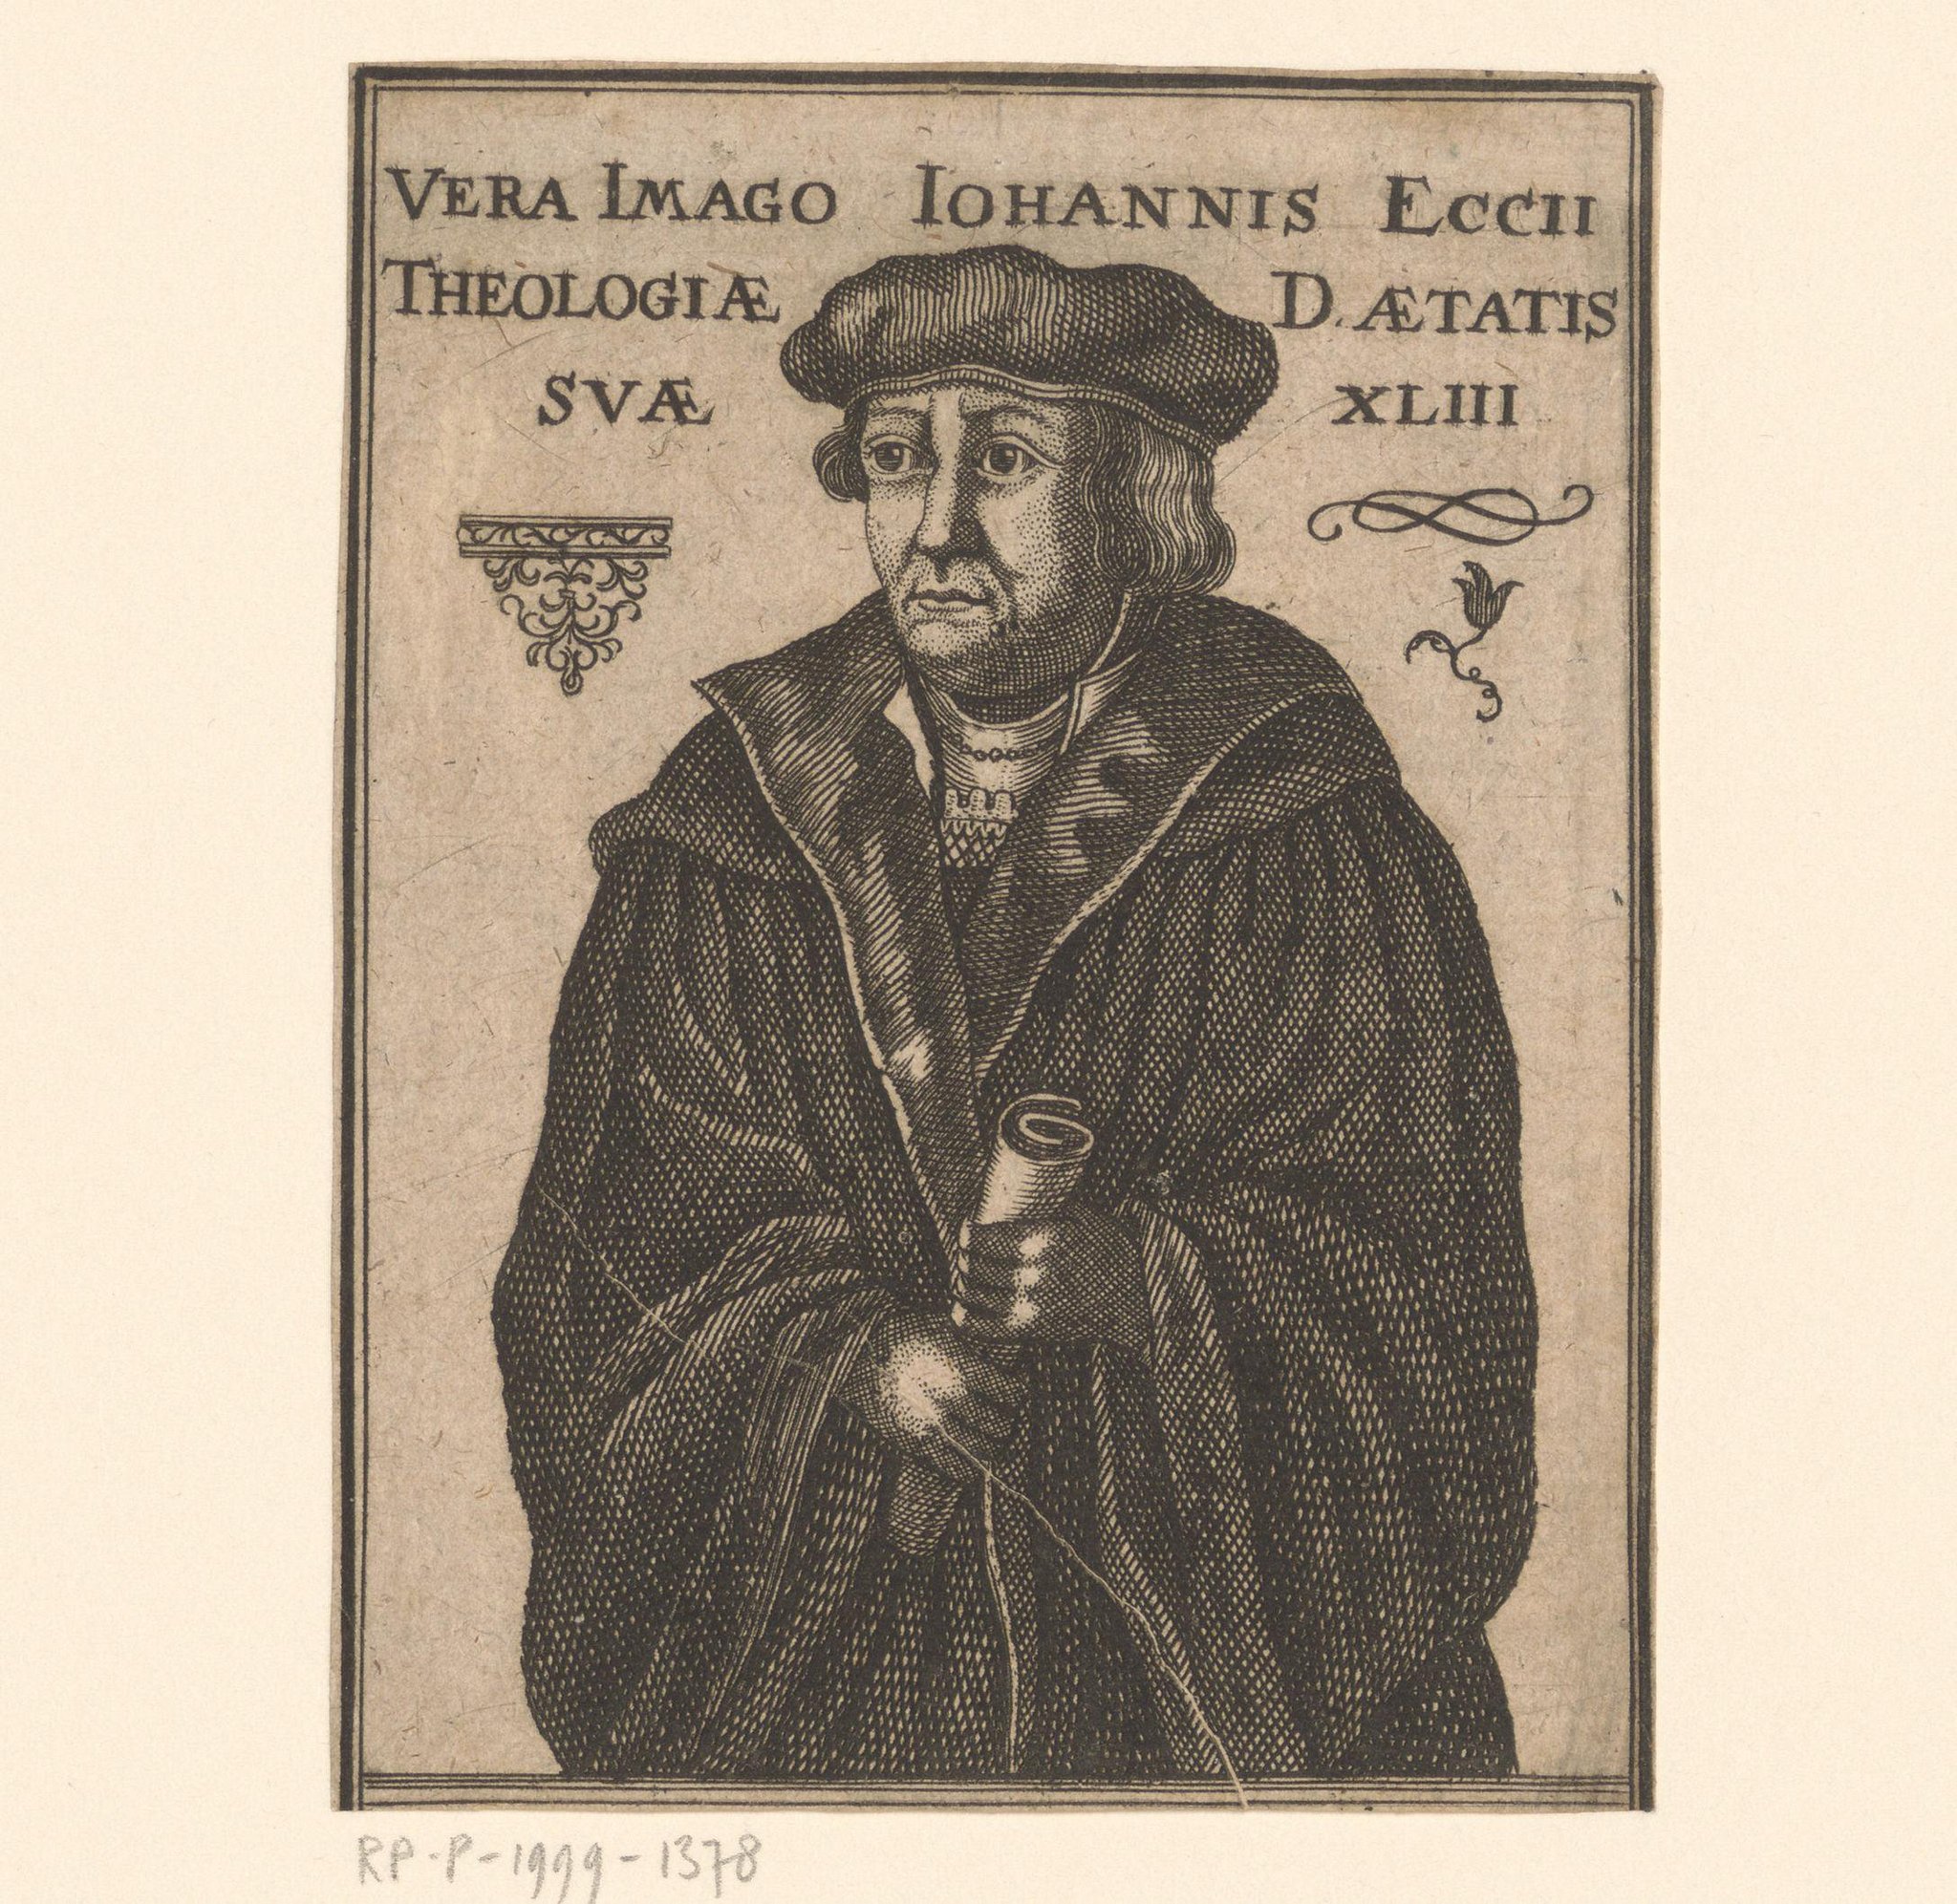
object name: print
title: Portret van Johannes Eck op 43-jarige leeftijd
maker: Anonymous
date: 1580-1650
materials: paper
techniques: engraving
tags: theologian, historical persons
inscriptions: collector's mark: Lugt 2760, collector's mark: Lugt 2228